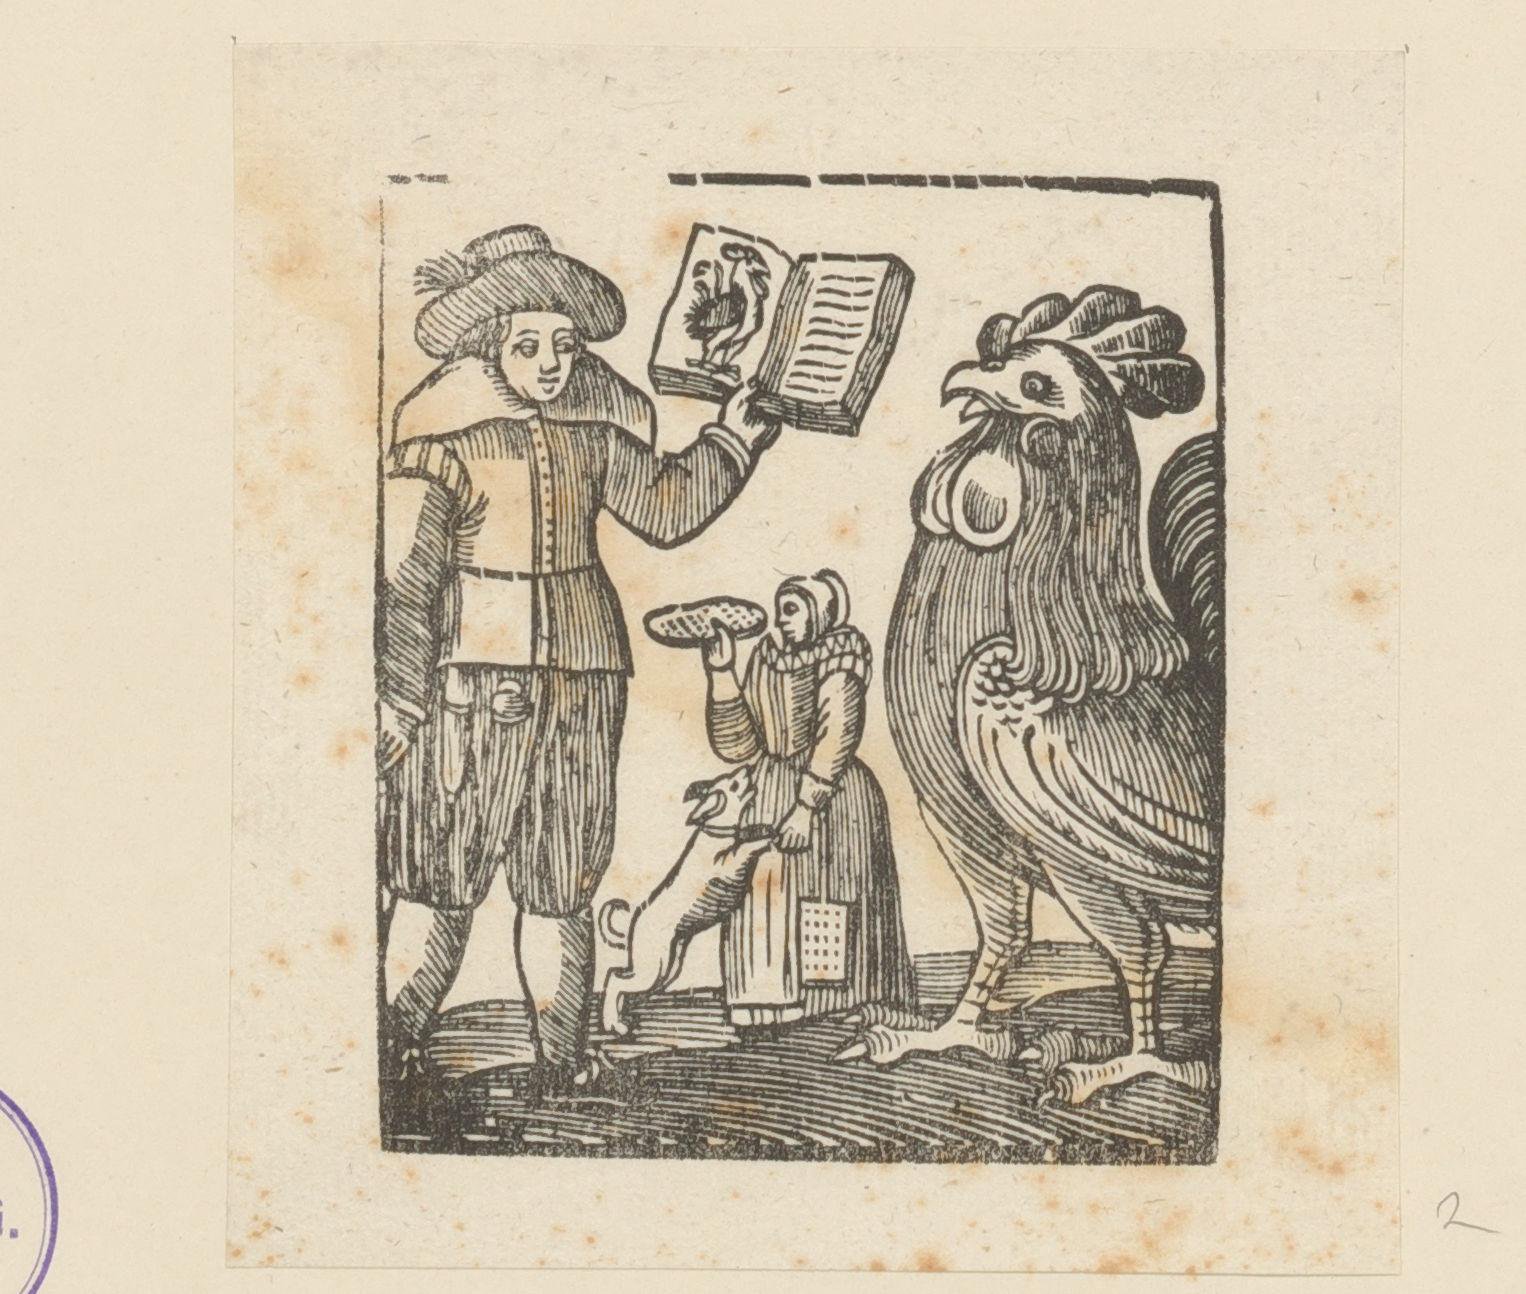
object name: print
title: Man houdt een haneboek open voor een haan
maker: Anonymous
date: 1778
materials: paper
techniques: woodcut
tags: book - mm - book open, fowl (cock, hen, chicken, etc.)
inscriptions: collector's mark: Lugt 1641, stamp, stamp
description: Onderwerpsrubrieken binnen de Atlas Zeden en Gewoonten: Onderwijs en Wetenschappen, Opvoeding en Onderwijs, Haneboeken en schoolprenten.